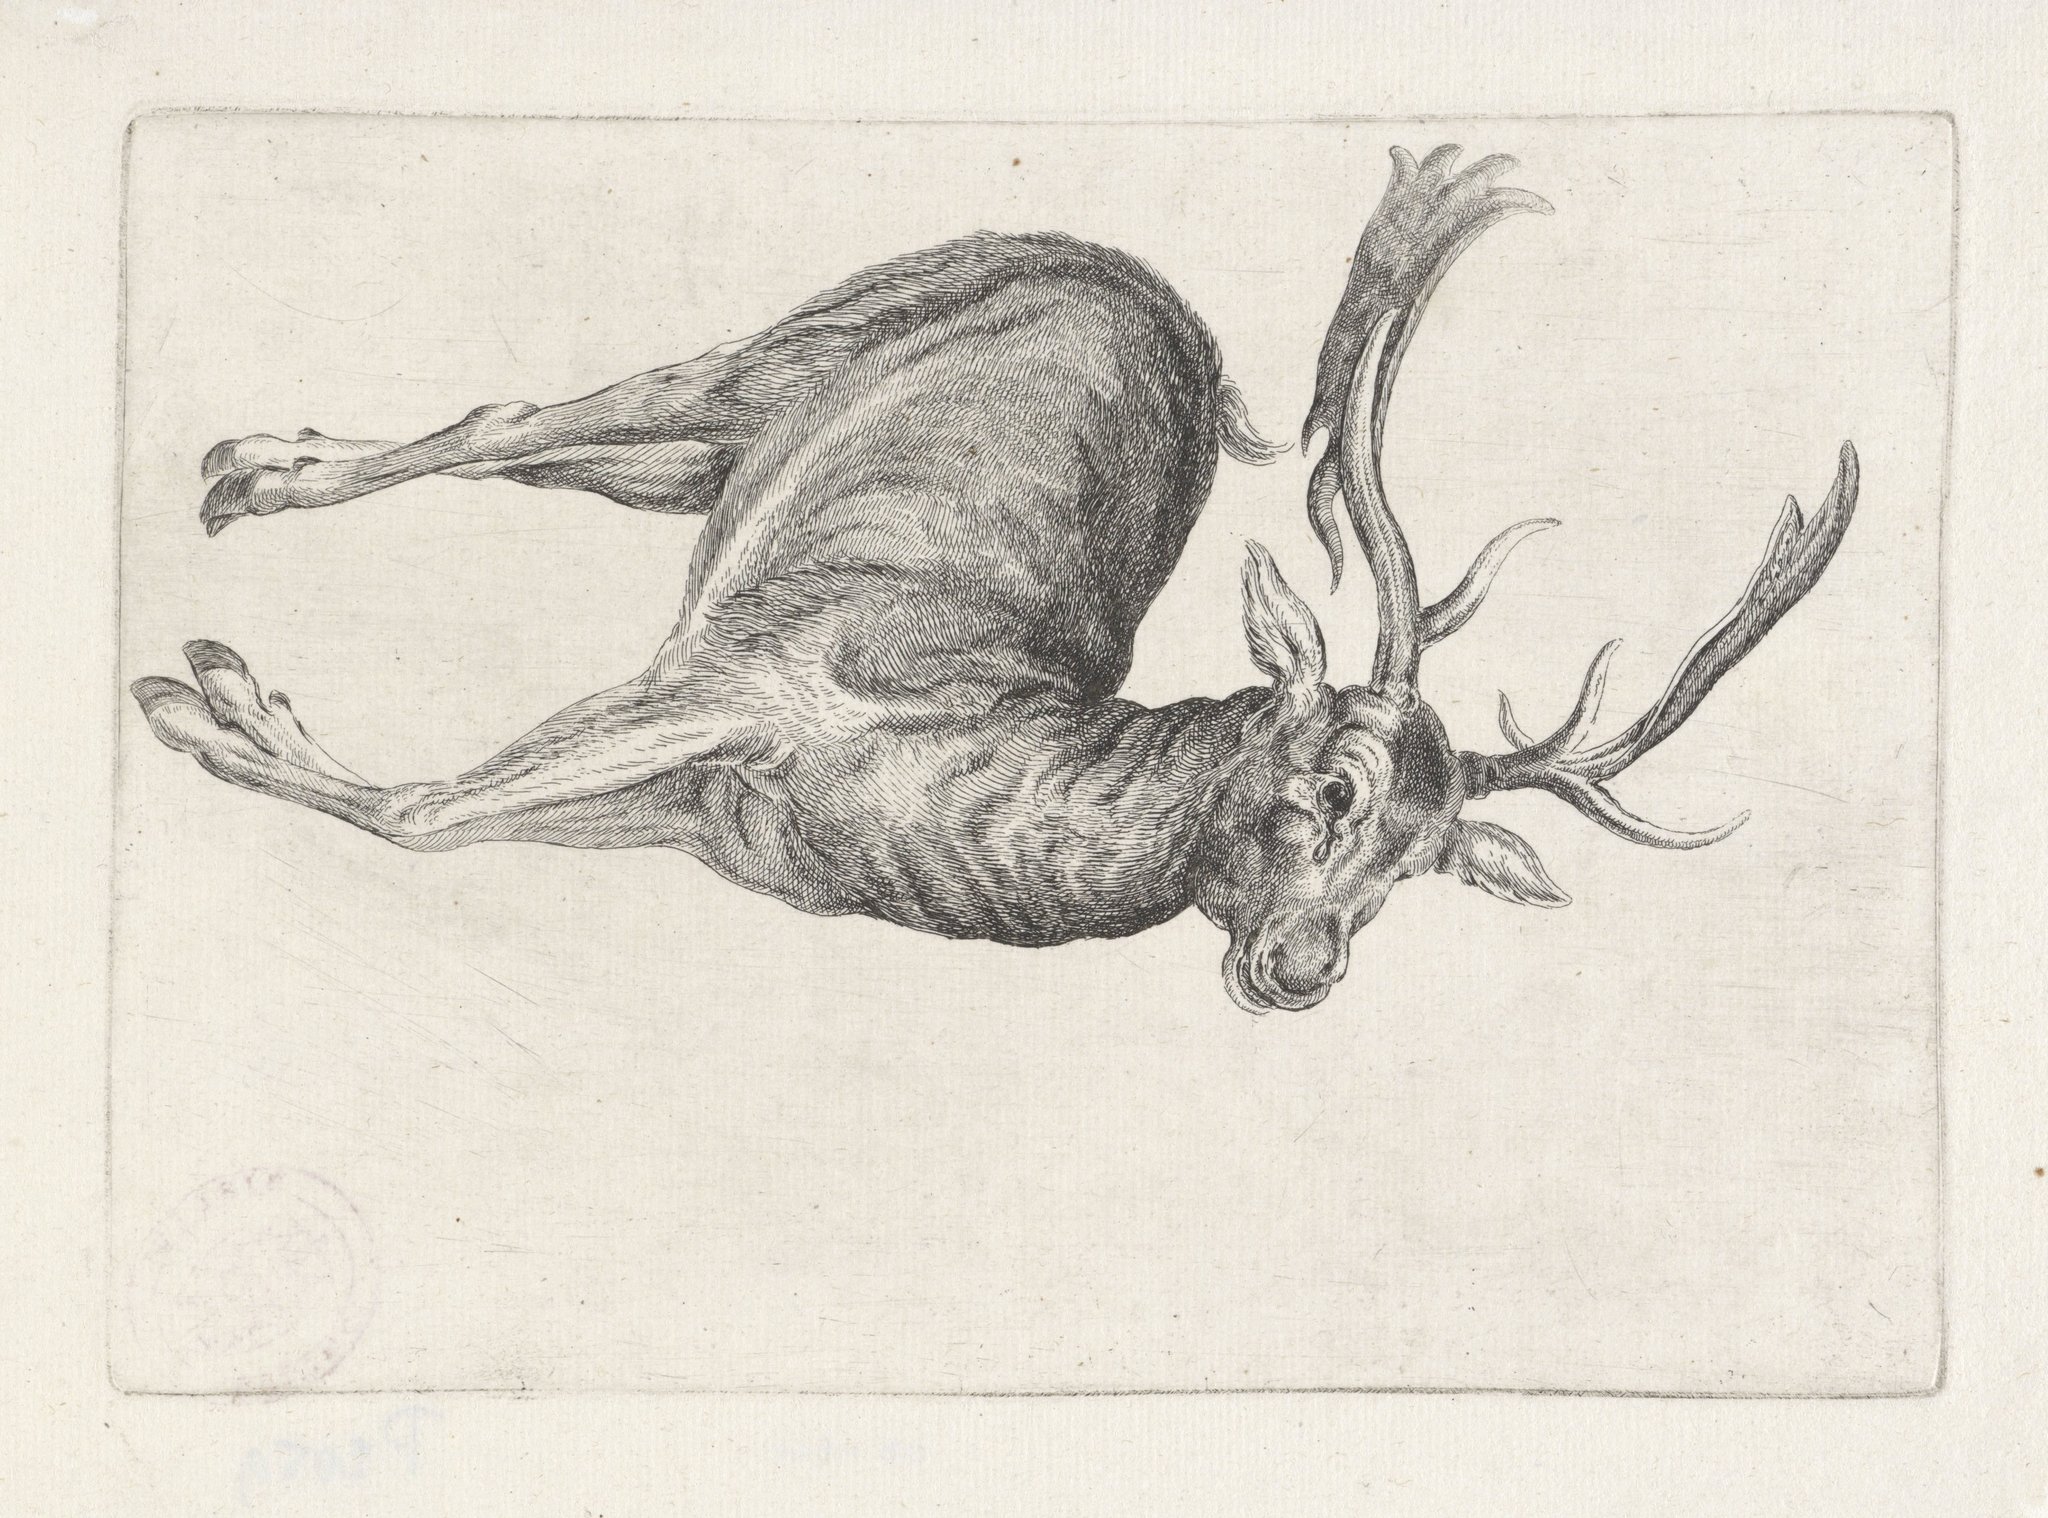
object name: print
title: Geschoten wild: een dood hert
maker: wenceslaus hollar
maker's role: draughtsman, print maker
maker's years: 1607-1677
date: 1646-1647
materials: paper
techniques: etching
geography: antwerp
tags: hoofed animals: deer, spoils of the hunt, game, venison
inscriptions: collector's mark: Lugt 240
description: Prent uit twintigdelige serie (incl. titelprent) met voorstellingen over de jacht: "Jacht, jachthonden en wild".